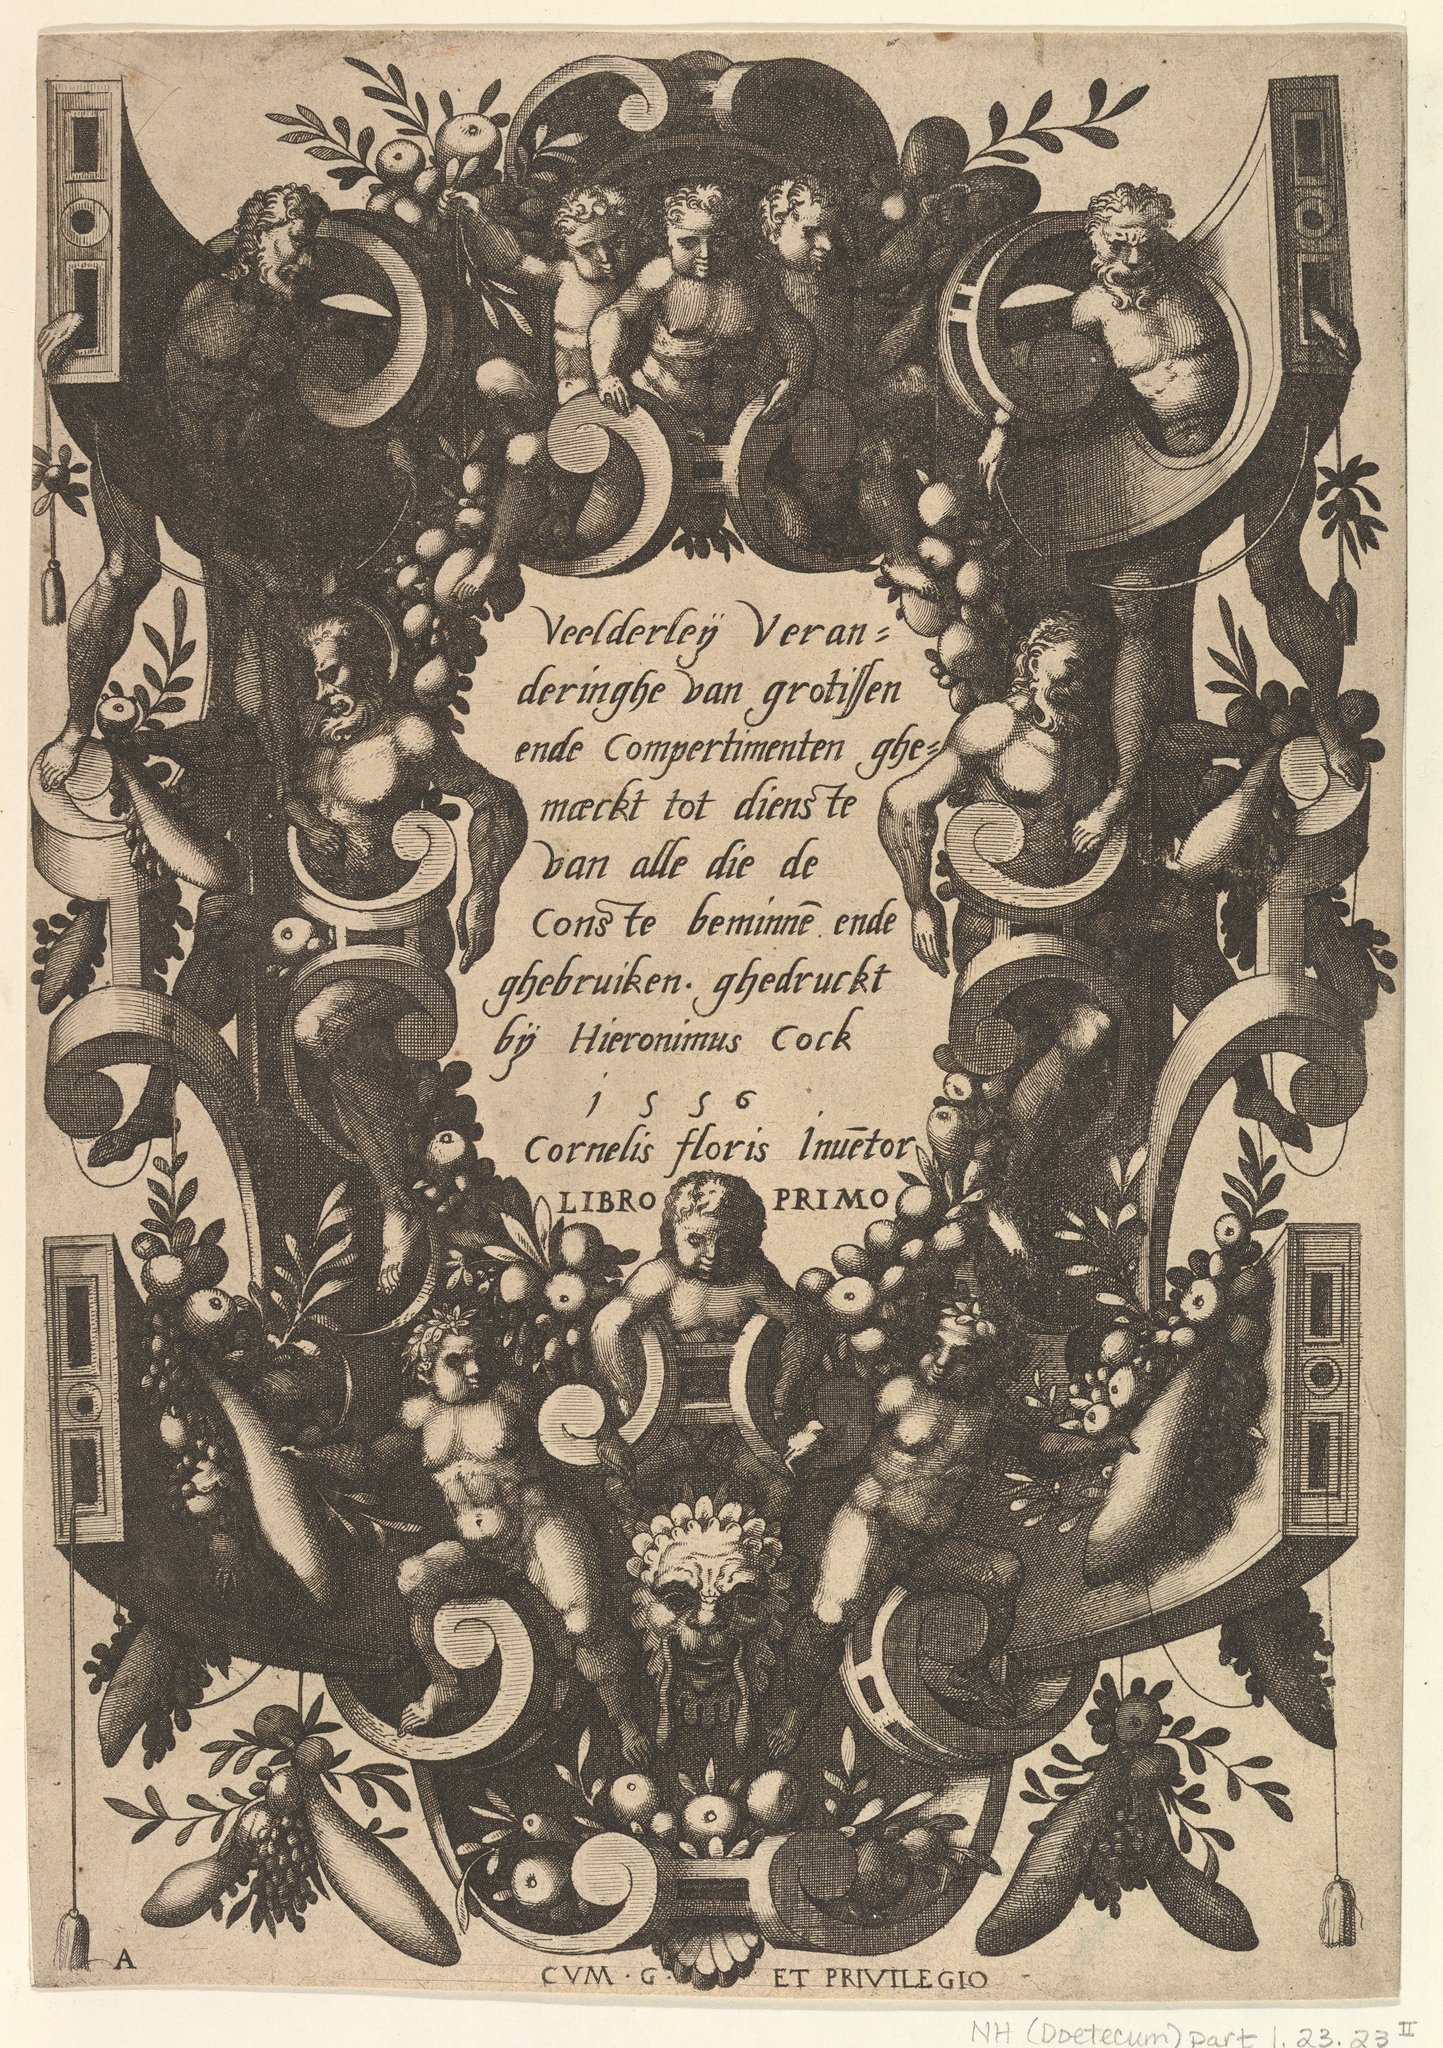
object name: book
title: [Four plates of ornamental panels]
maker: cornelis floris ii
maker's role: artist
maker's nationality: netherlandish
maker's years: 1514-1575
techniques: etching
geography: belgium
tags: ornament,children,men